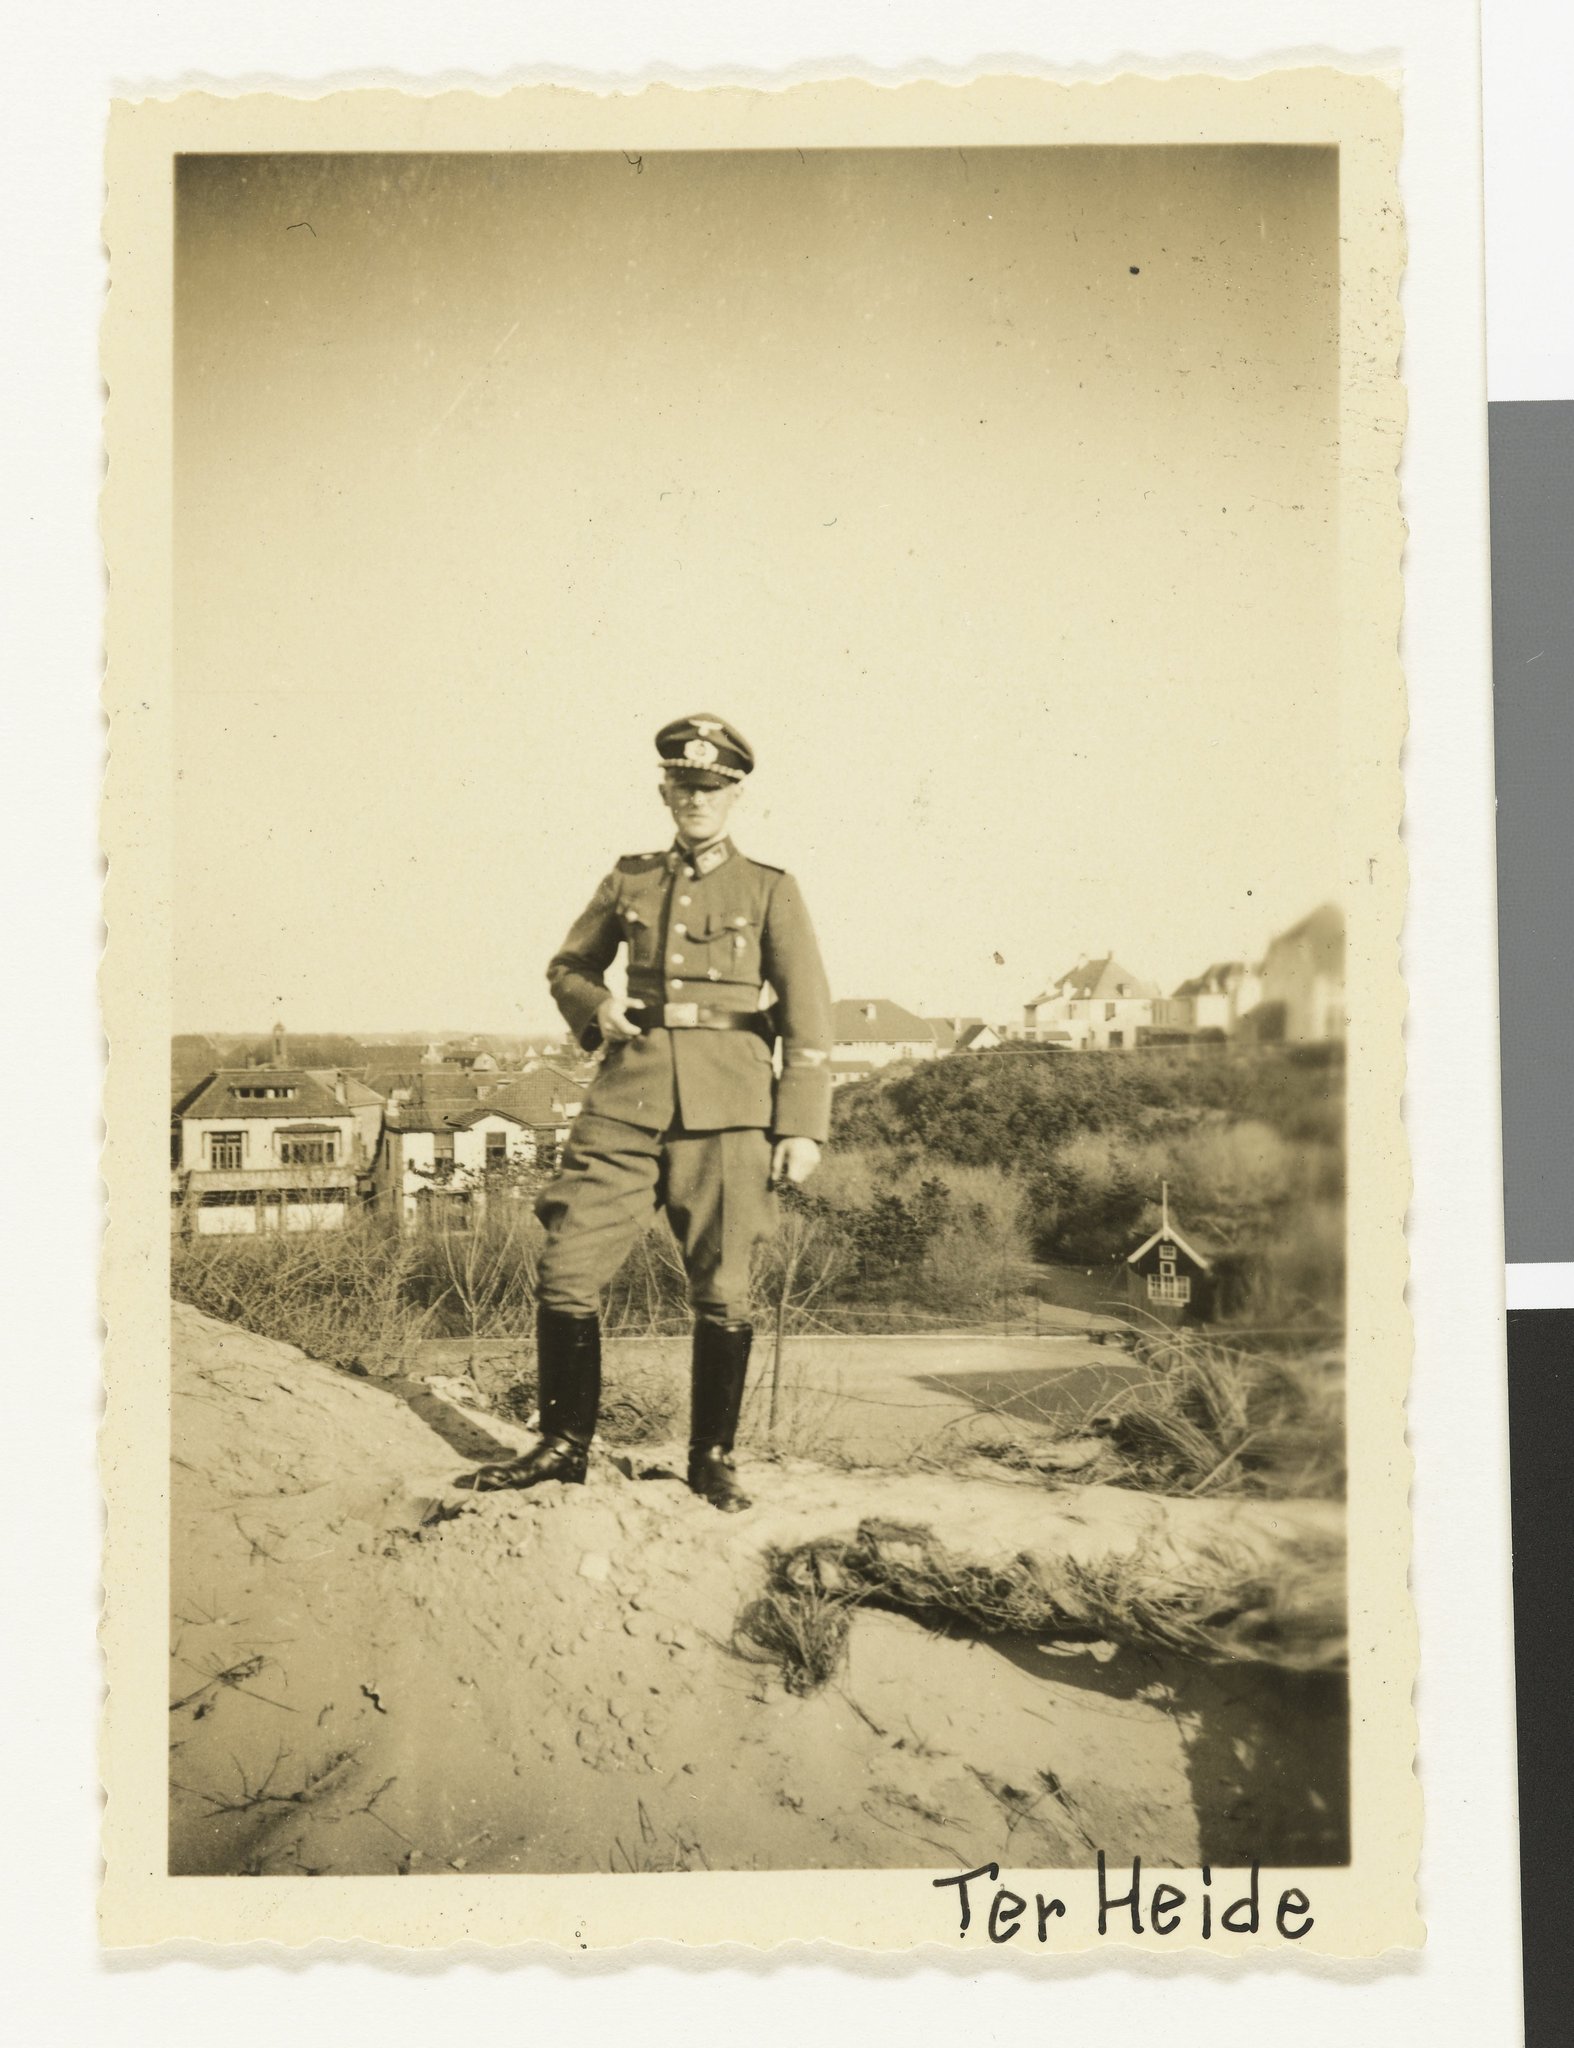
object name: photograph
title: Hoge Wehrmacht militair in de duinen bij Noordwijk aan Zee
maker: Anonymous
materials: photographic support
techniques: gelatin silver print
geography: noordwijk aan zee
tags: occupation ~ war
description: Een hoge Wehrmacht militair staat in de duinen bij Huis ter Duin in Noordwijk aan Zee. Op de achtergrond huizen en de toren van De Buurtkerk.